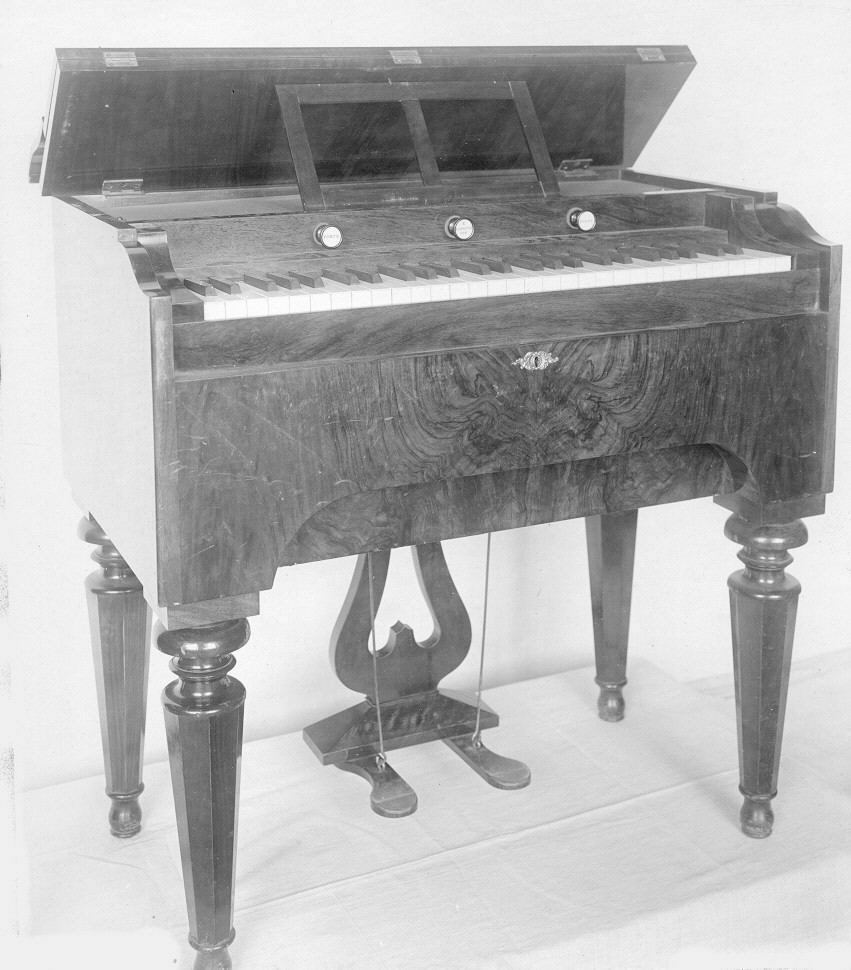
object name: harmonium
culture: german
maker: f. kaufmann & sohn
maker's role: maker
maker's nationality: german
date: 1834-1866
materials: wood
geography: germany